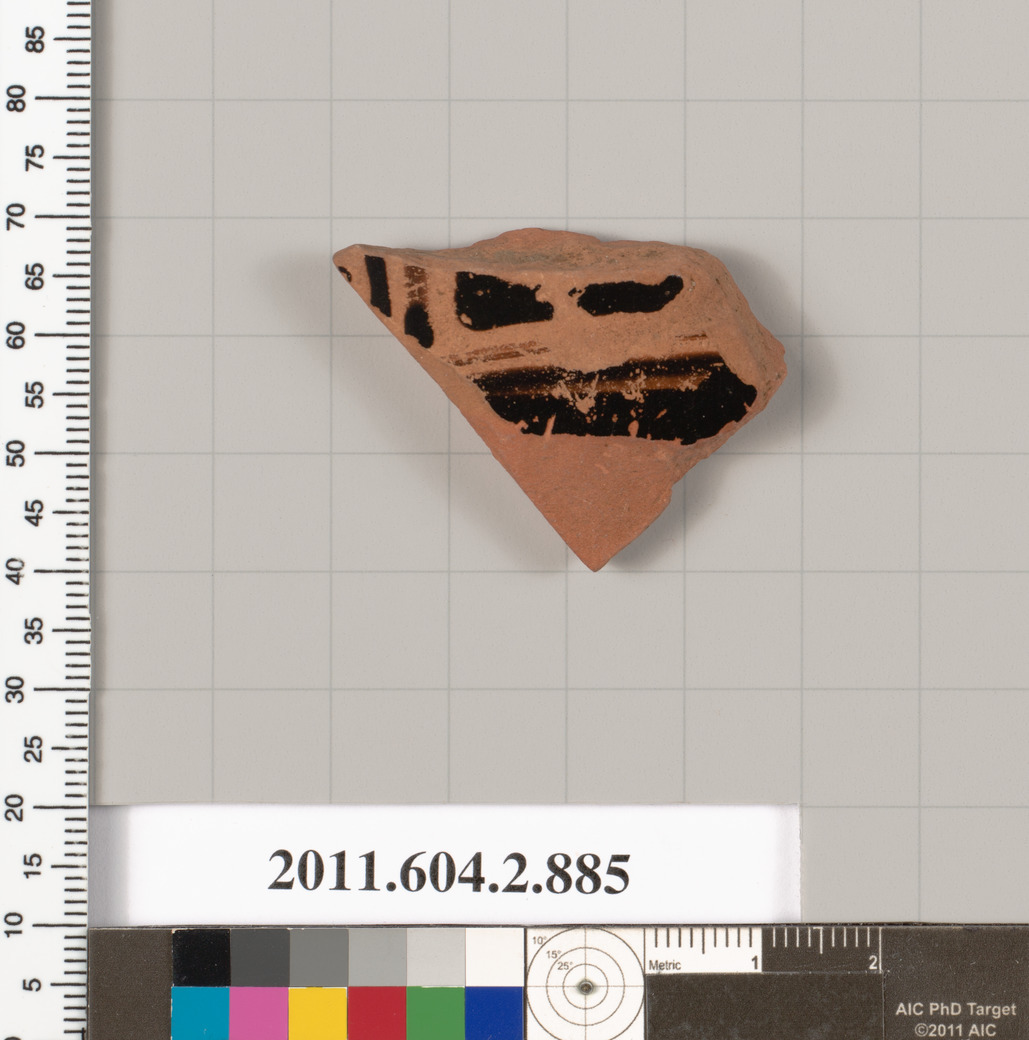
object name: bell krater fragment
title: Terracotta fragment of a bell-krater (bowl for mixing wine and water)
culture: greek, attic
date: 450-426 BCE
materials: terracotta